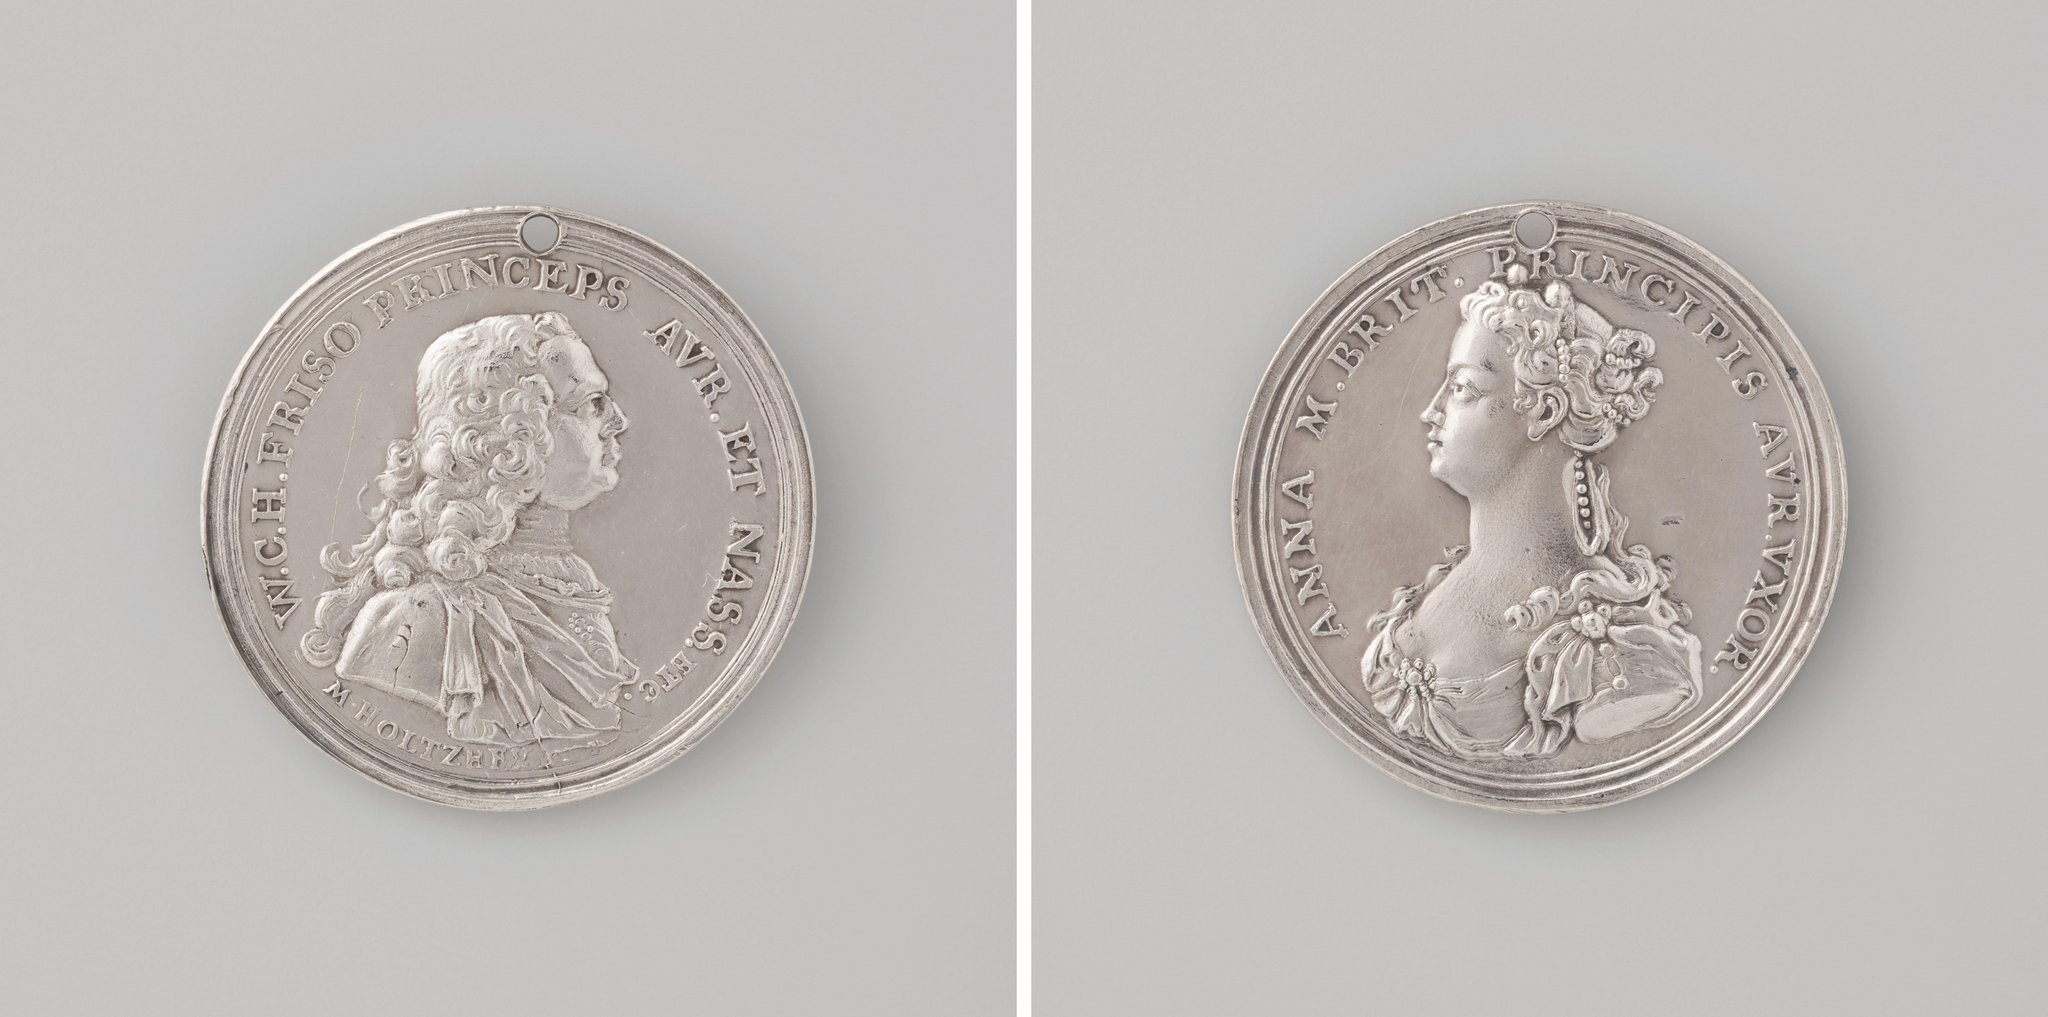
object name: history medal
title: Huwelijk van Willem IV met prinses Anna van Engeland te Londen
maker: martinus holtzhey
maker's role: medailleur, muntmaker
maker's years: 1697-1764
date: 1734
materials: silver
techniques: striking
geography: amsterdam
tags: the hague, willem iv (prins van oranje-nassau), anna van hannover, london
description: Zilveren penning met gat erin. Voorzijde: borststuk man binnen omschrift. Keerzijde: borststuk vrouw binnen omschrift